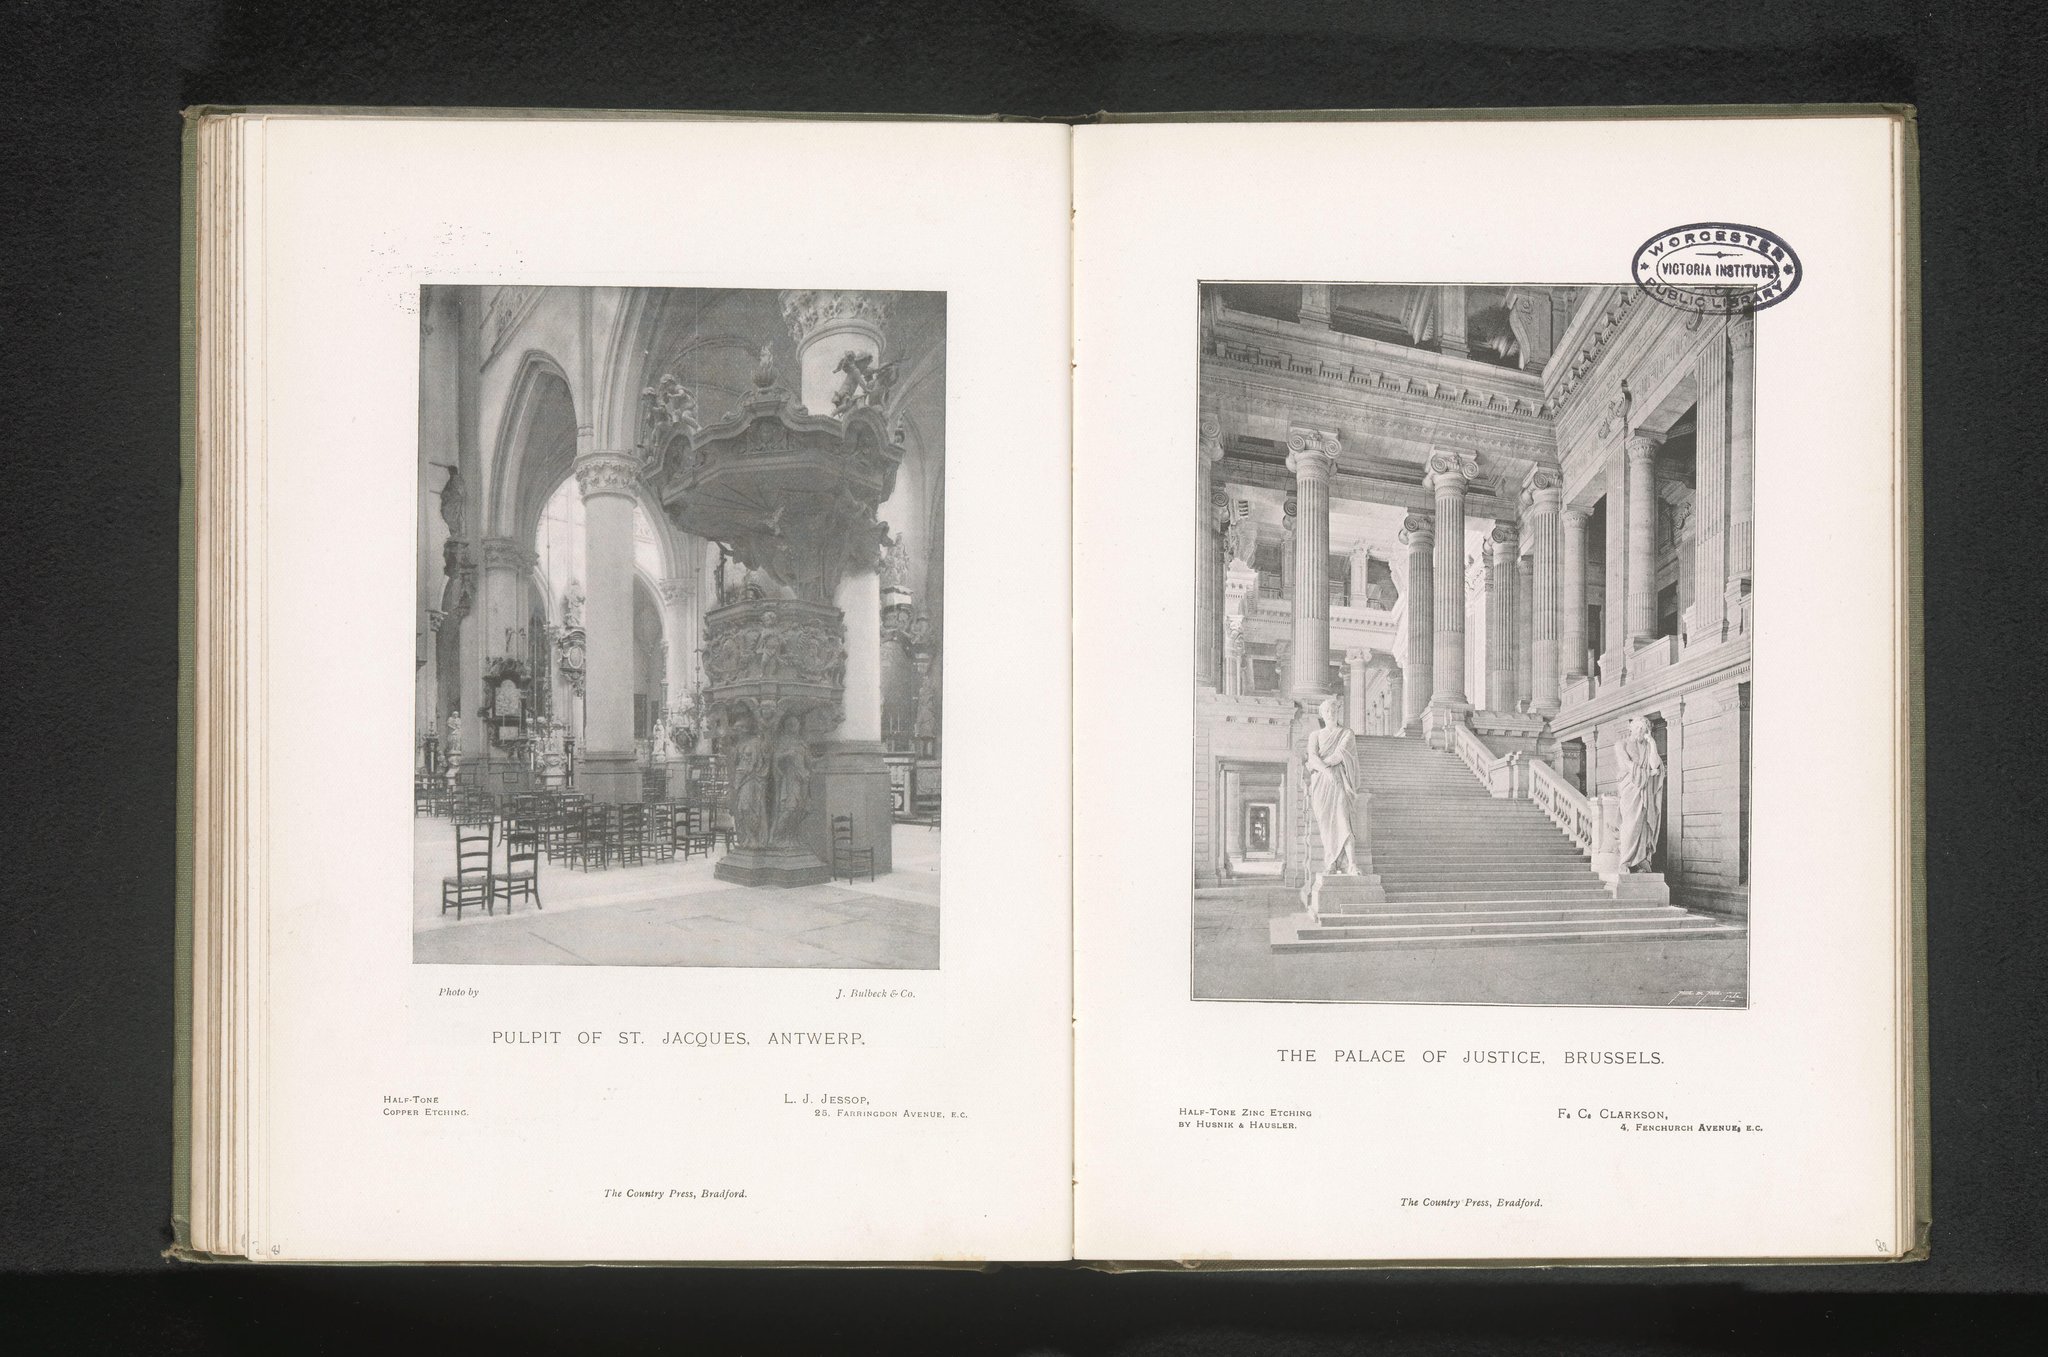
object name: page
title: Pulpit of St. Jacques, Antwerp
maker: lewis j. jessop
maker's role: clichémaker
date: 1893-1898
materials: paper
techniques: autotype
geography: antwerpen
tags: pulpit, ambo, chancel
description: Prent op tweede ongenummerde pagina na pagina 96.